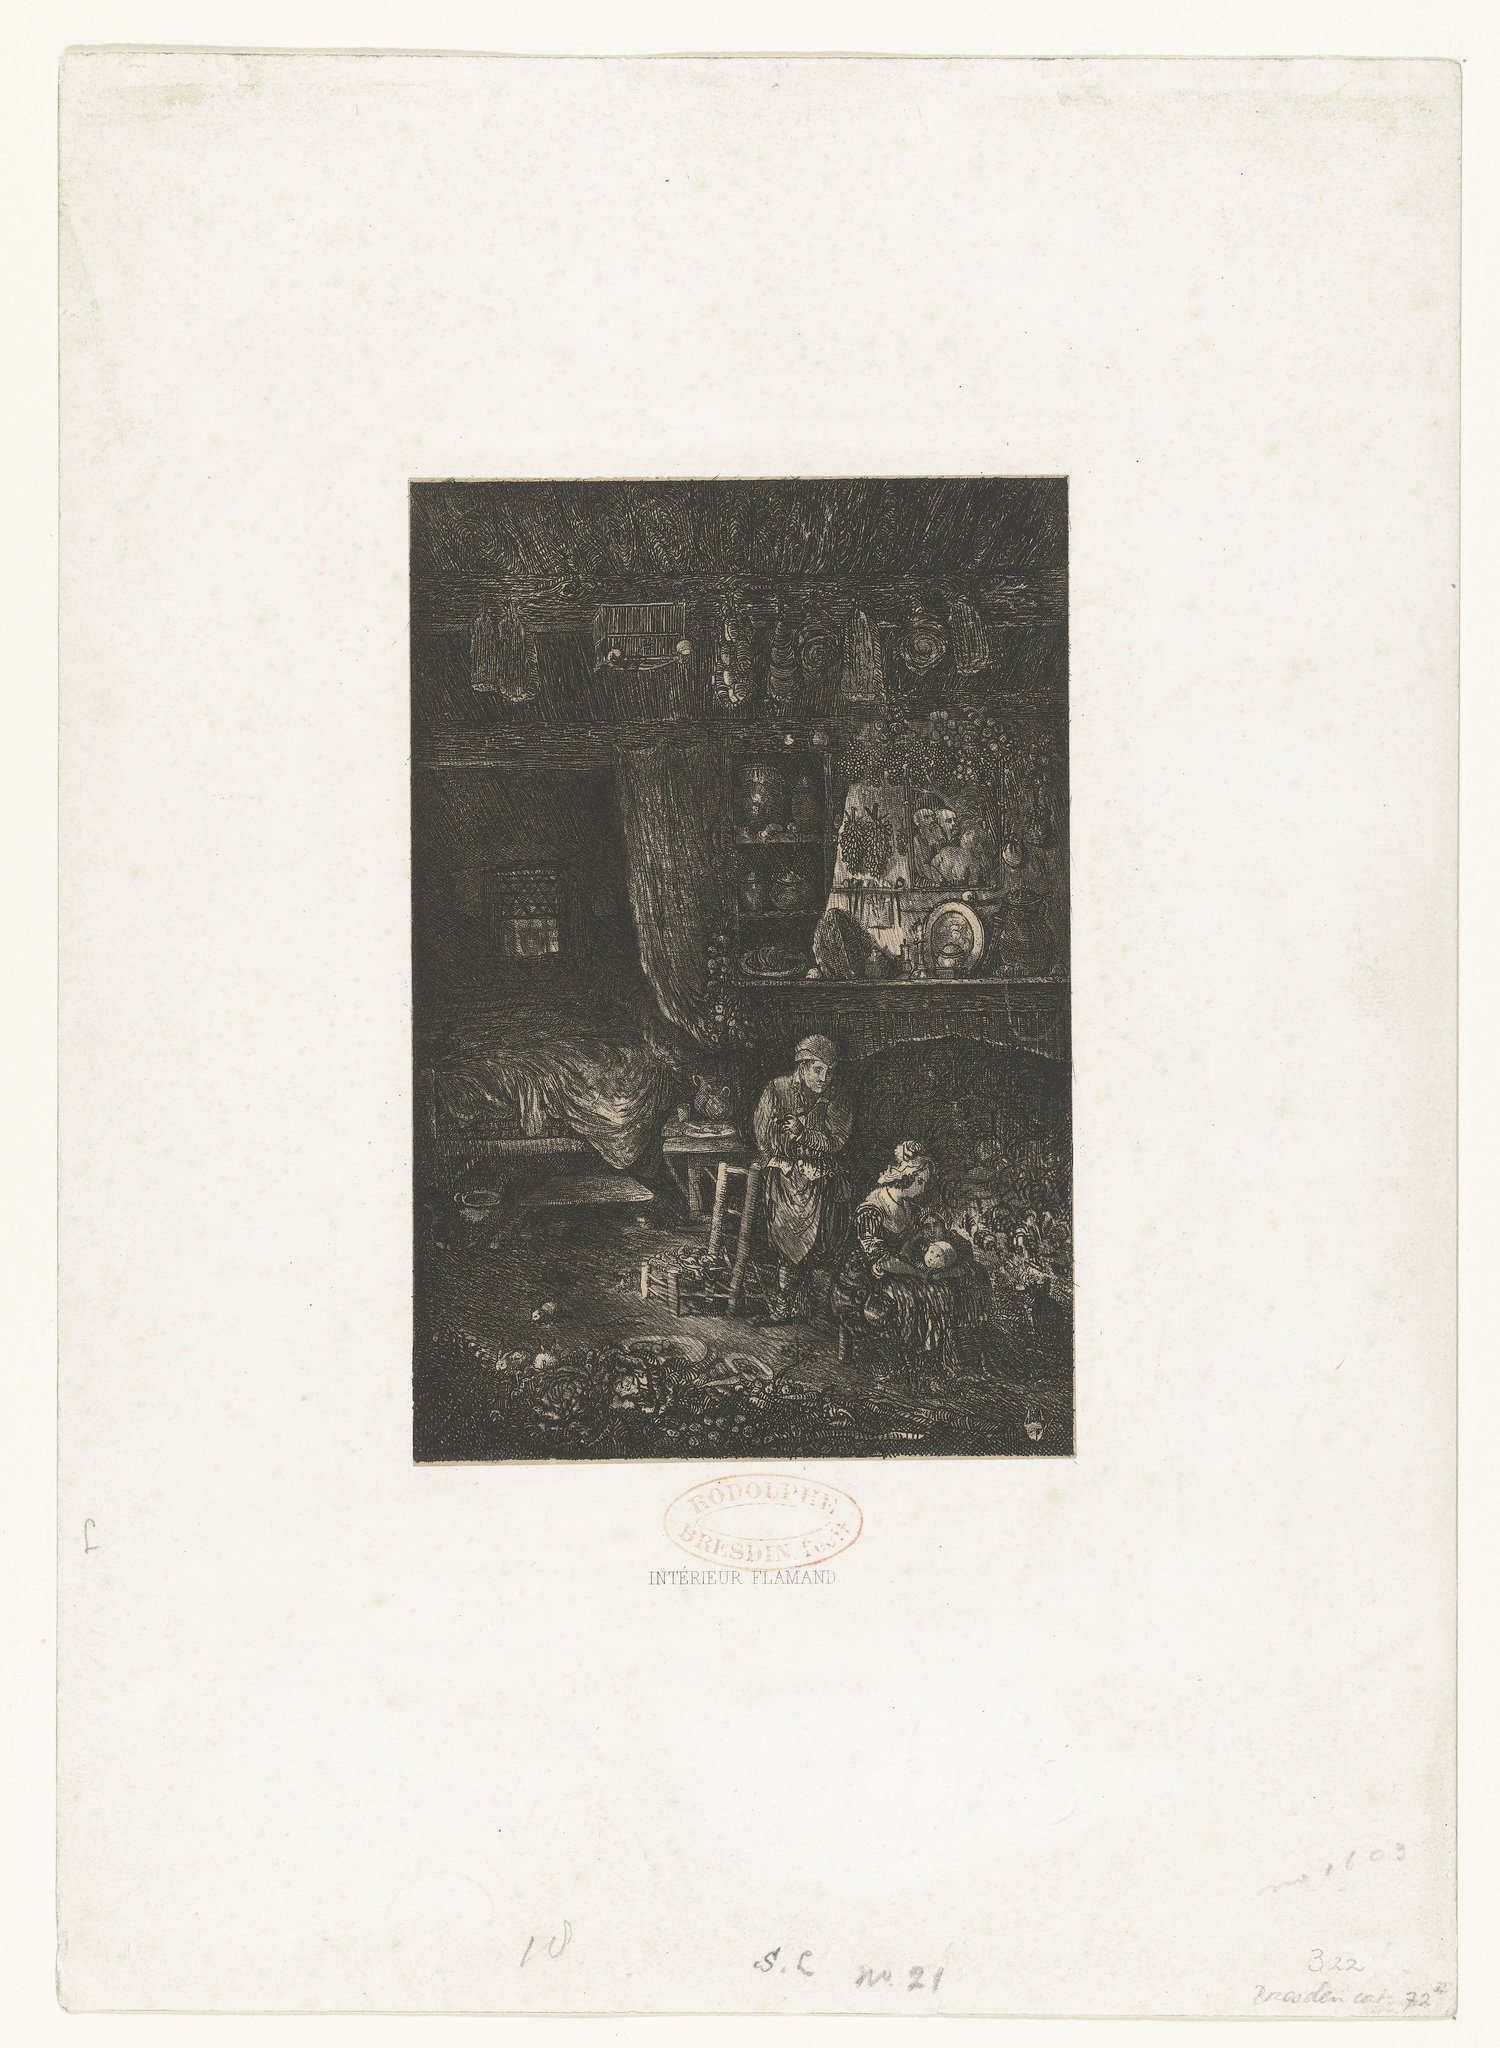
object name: print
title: Intérieure flamand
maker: rodolphe bresdin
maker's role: draughtsman, print maker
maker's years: 1822-1885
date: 1856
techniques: printmaking, lithograph, roulette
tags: farmers, interior of the house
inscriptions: collector's mark: Lugt 295b, collector's mark: Lugt 2228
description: Interieur met een vrouw zittend voor een haard met naast haar twee kinderen, een man staat achter haar en rookt een pijp. Het interieur is rijk aan details, aan de schouw hangen allerlei voorwerpen waaronder een voorstelling van Susanna en de Oudsten. Linksachter is een grote bedstede weergegeven. Aan de balken van het dak drogen hammen en op de grond liggen groenten waaraan geknabbeld wordt door konijnen en muizen.